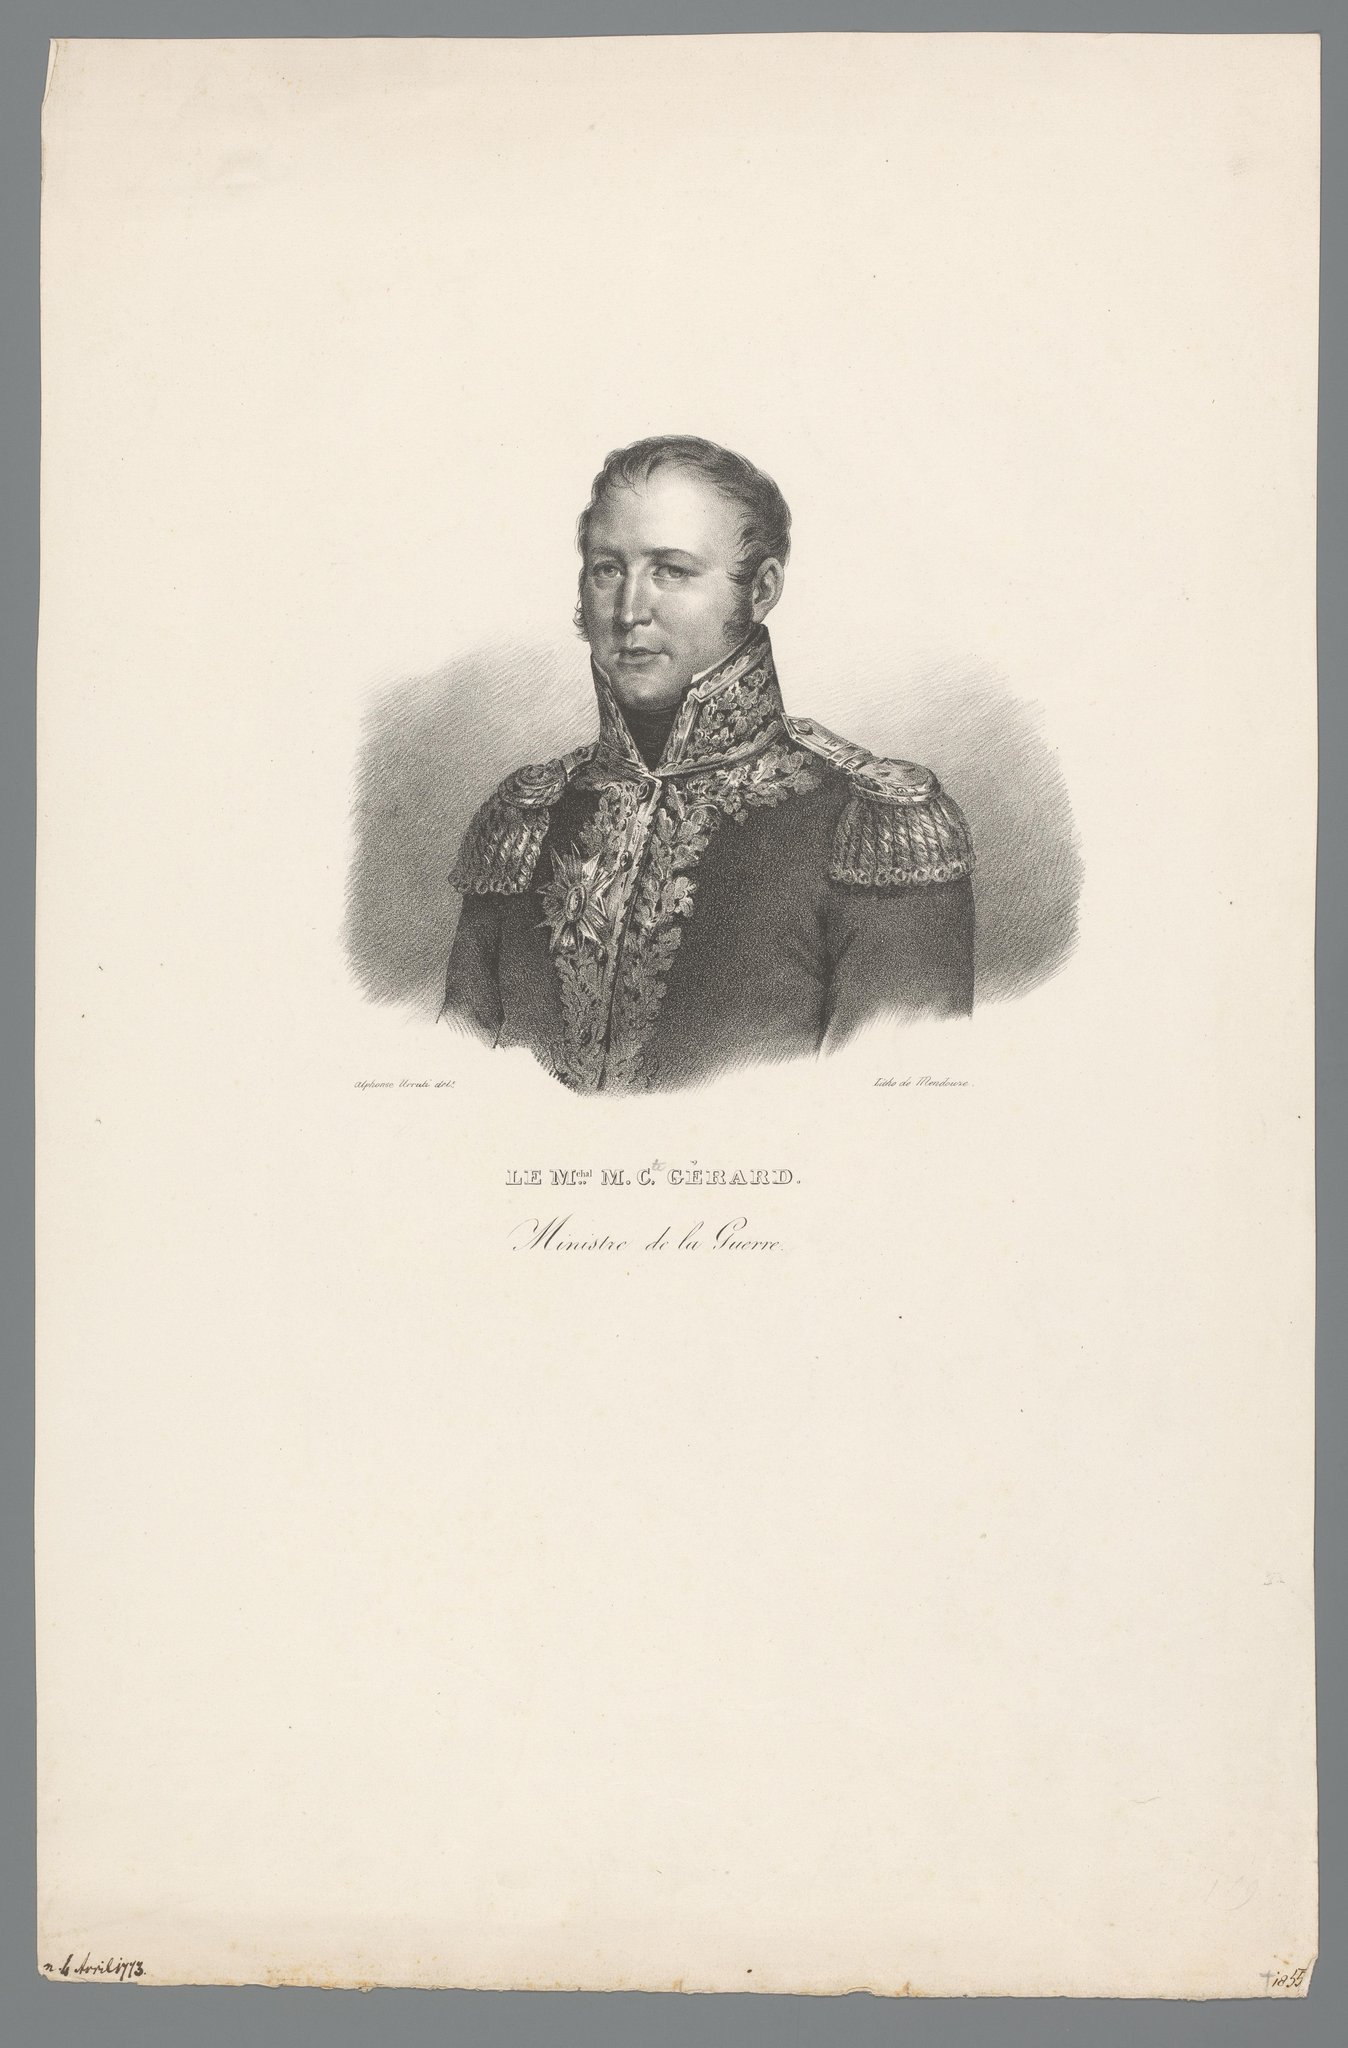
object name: print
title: Le mchal. M.C. Gérard, ministre de guerre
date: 1828-1834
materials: paper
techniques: lithograph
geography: paris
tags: historical persons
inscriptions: collector's mark: Lugt 2228